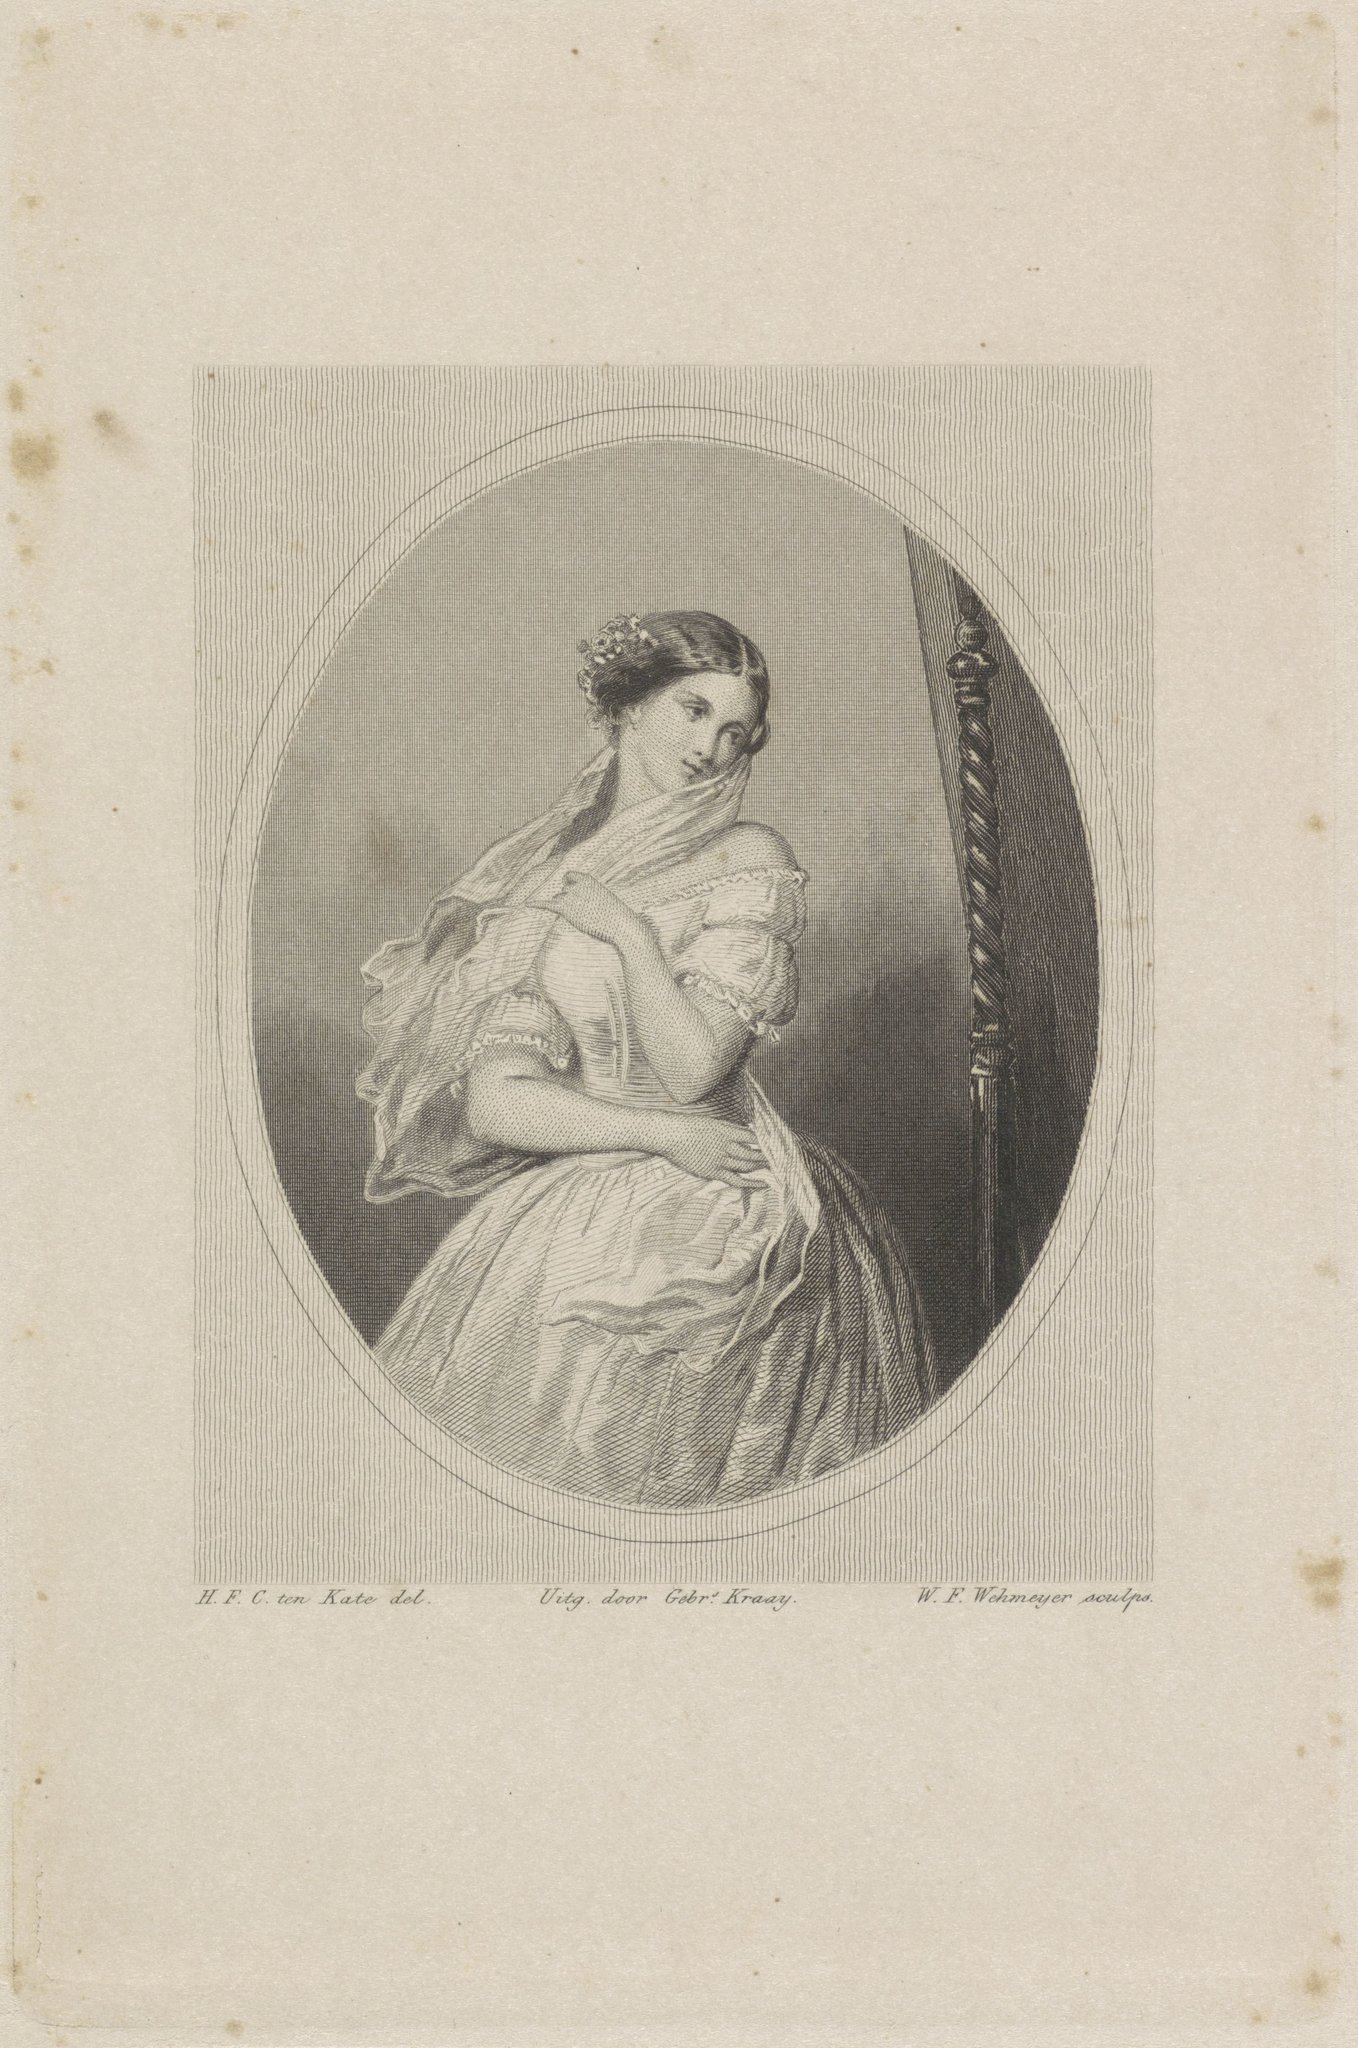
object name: print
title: Jonge vrouw in bruidsjapon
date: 1837-1854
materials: paper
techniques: engraving, etching, roulette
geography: amsterdam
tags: adult woman, bride (in wedding-dress)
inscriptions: collector's mark: Lugt 2228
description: Een jonge vrouw staat in een interieur. Ze draagt een bruidsjapon, een sluier en bloemen in haar haar.